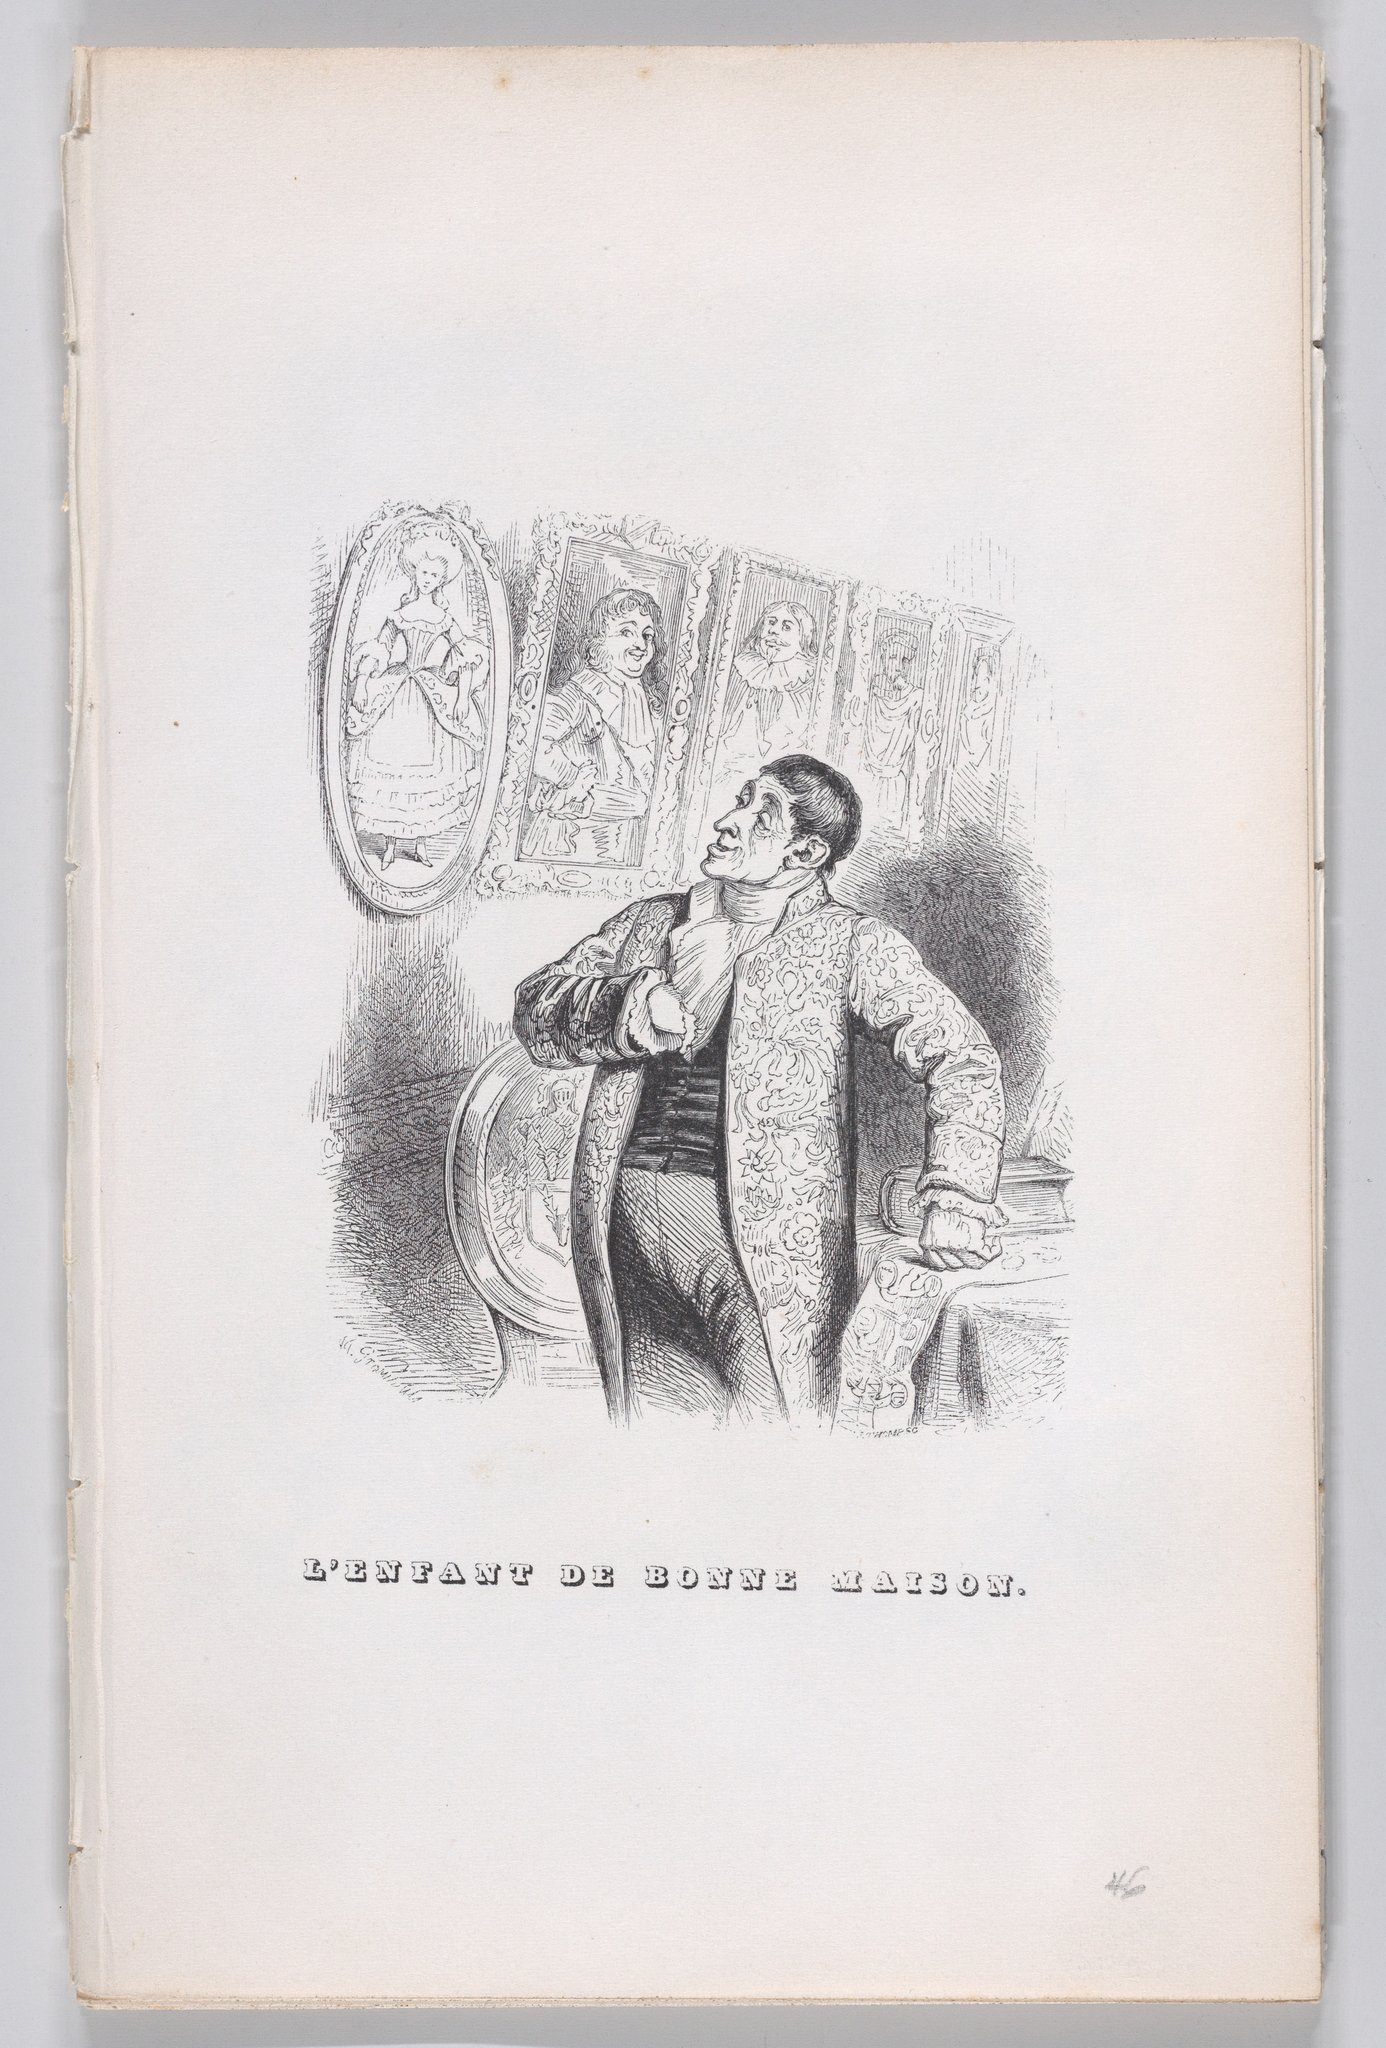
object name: print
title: The Child of Good Breeding, from "The Complete Works of Béranger"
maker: j. j. grandville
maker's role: illustrator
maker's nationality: french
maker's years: 1803-1847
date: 1836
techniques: engraving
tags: men